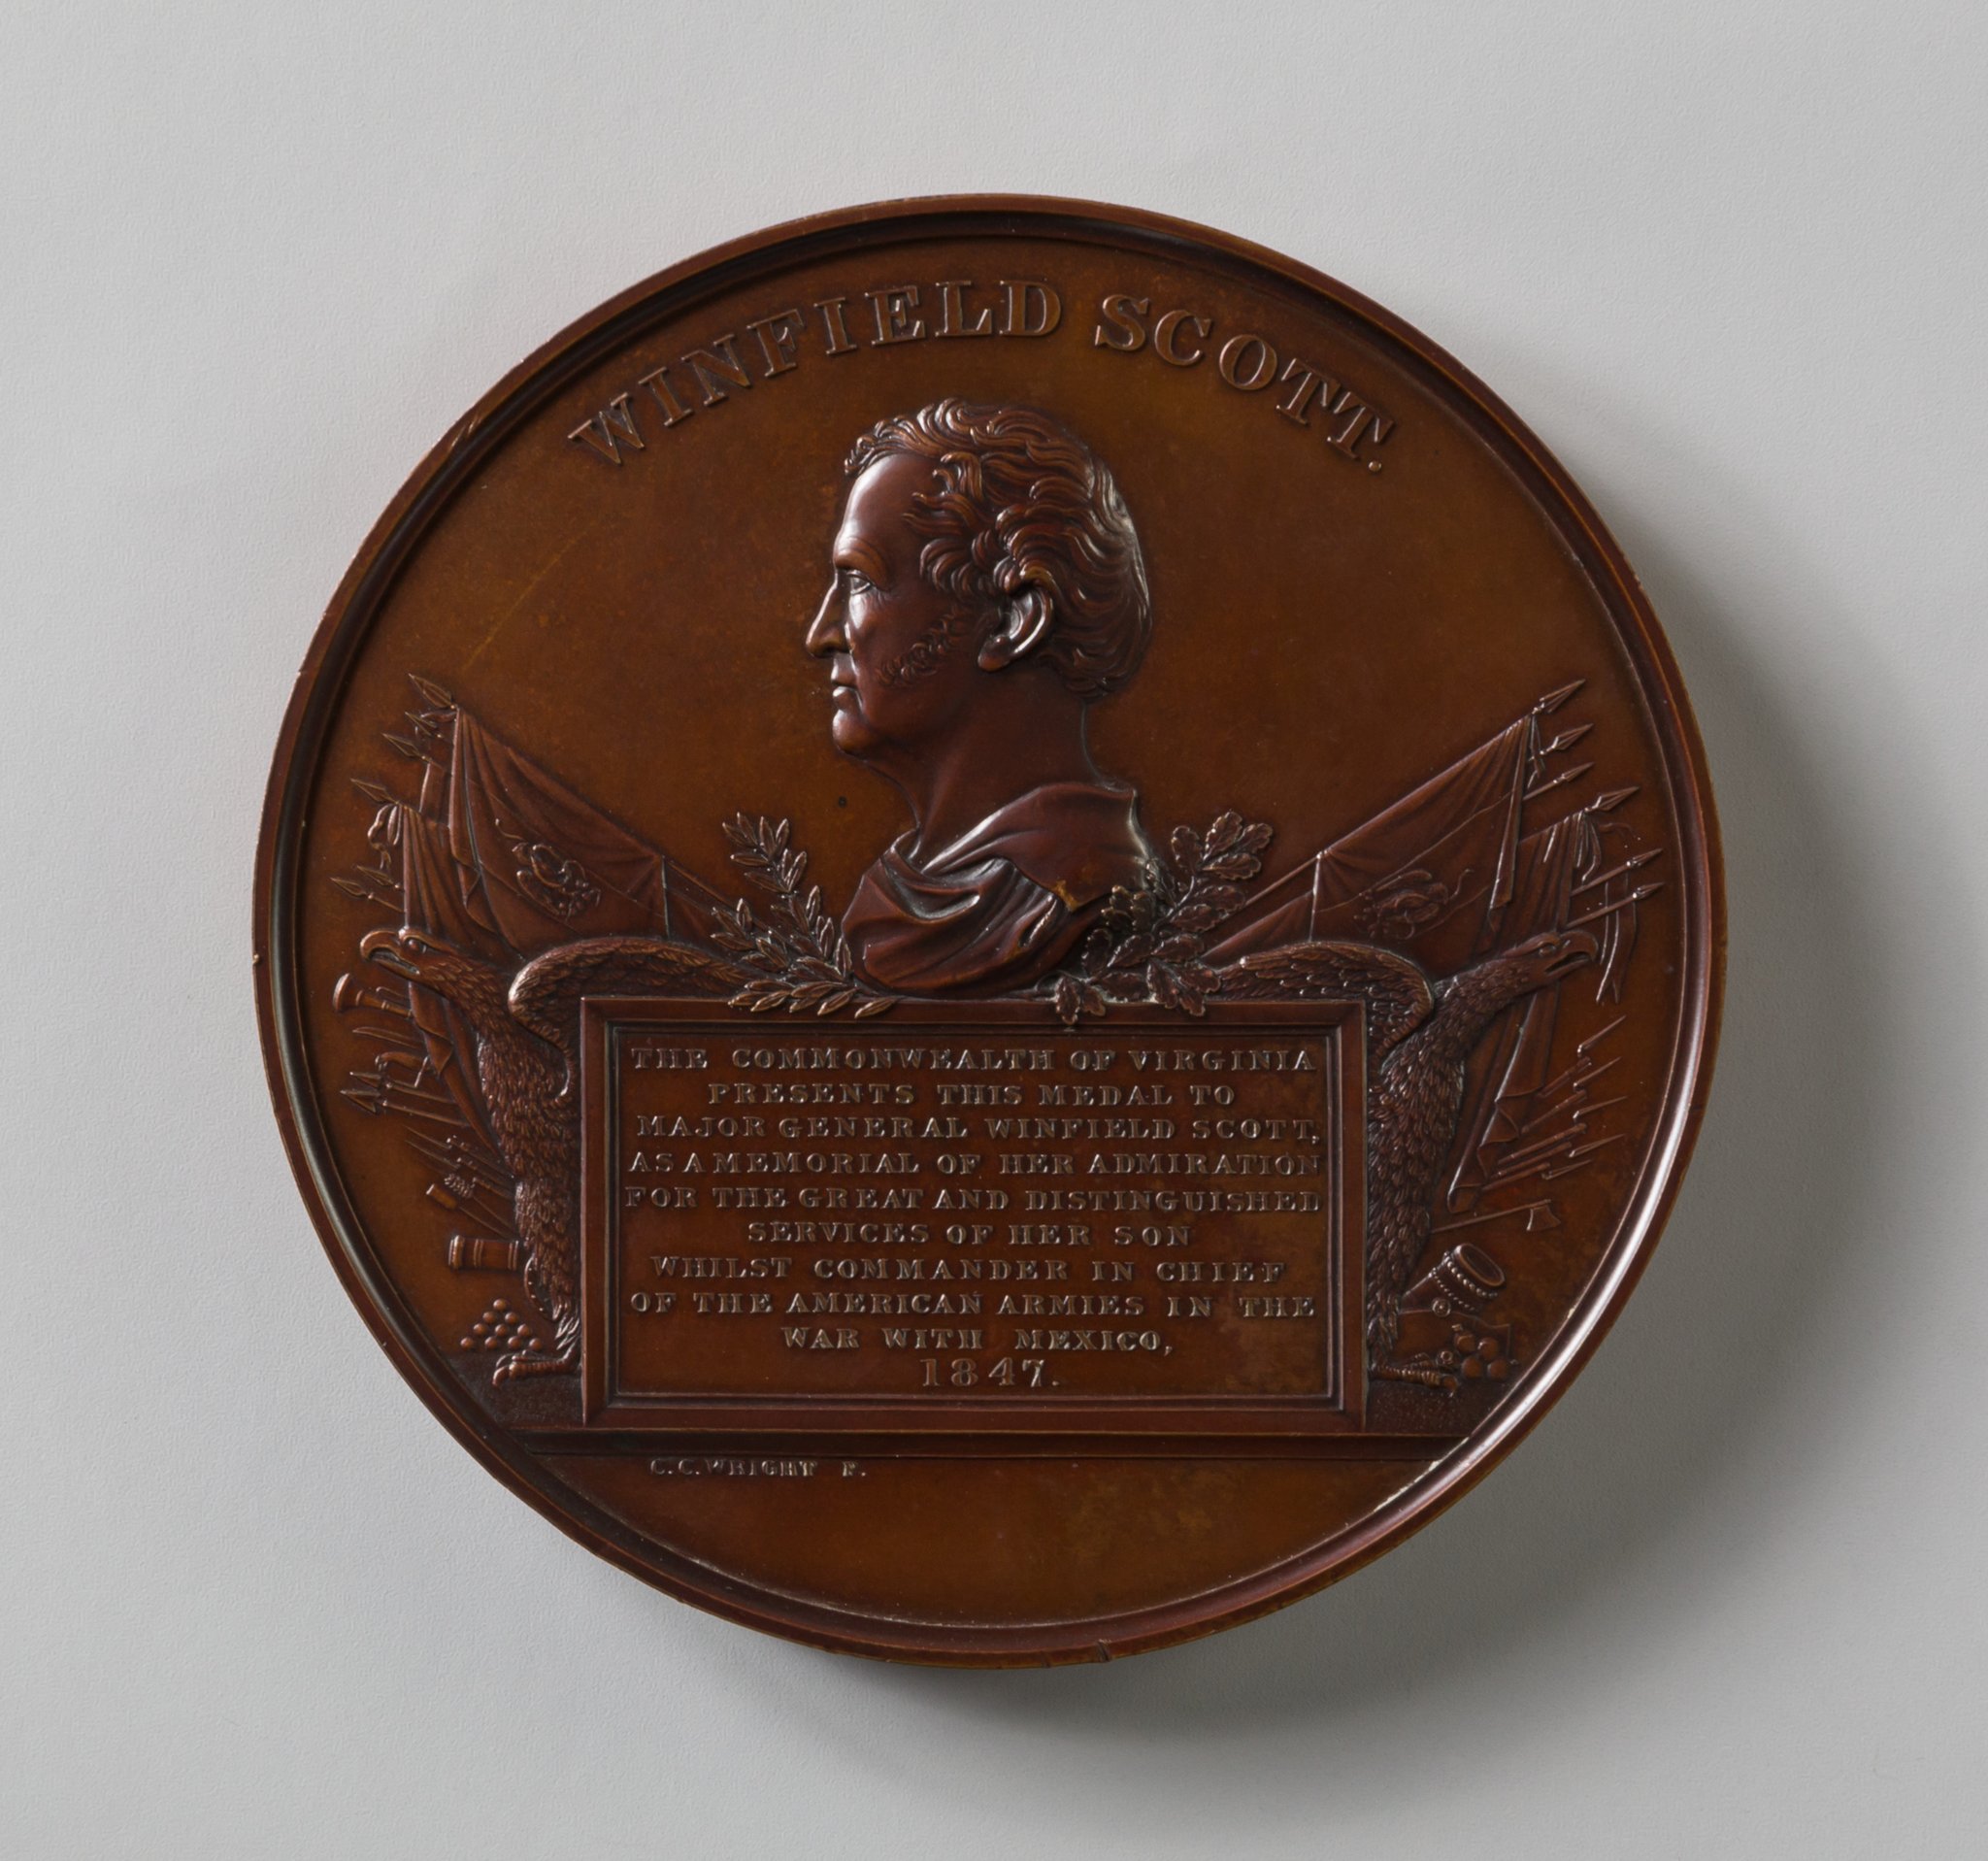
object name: medal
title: Medal of Major General Winfield Scott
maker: charles cushing wright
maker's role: maker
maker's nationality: american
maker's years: 1796-1854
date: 1847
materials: bronze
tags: men,profiles